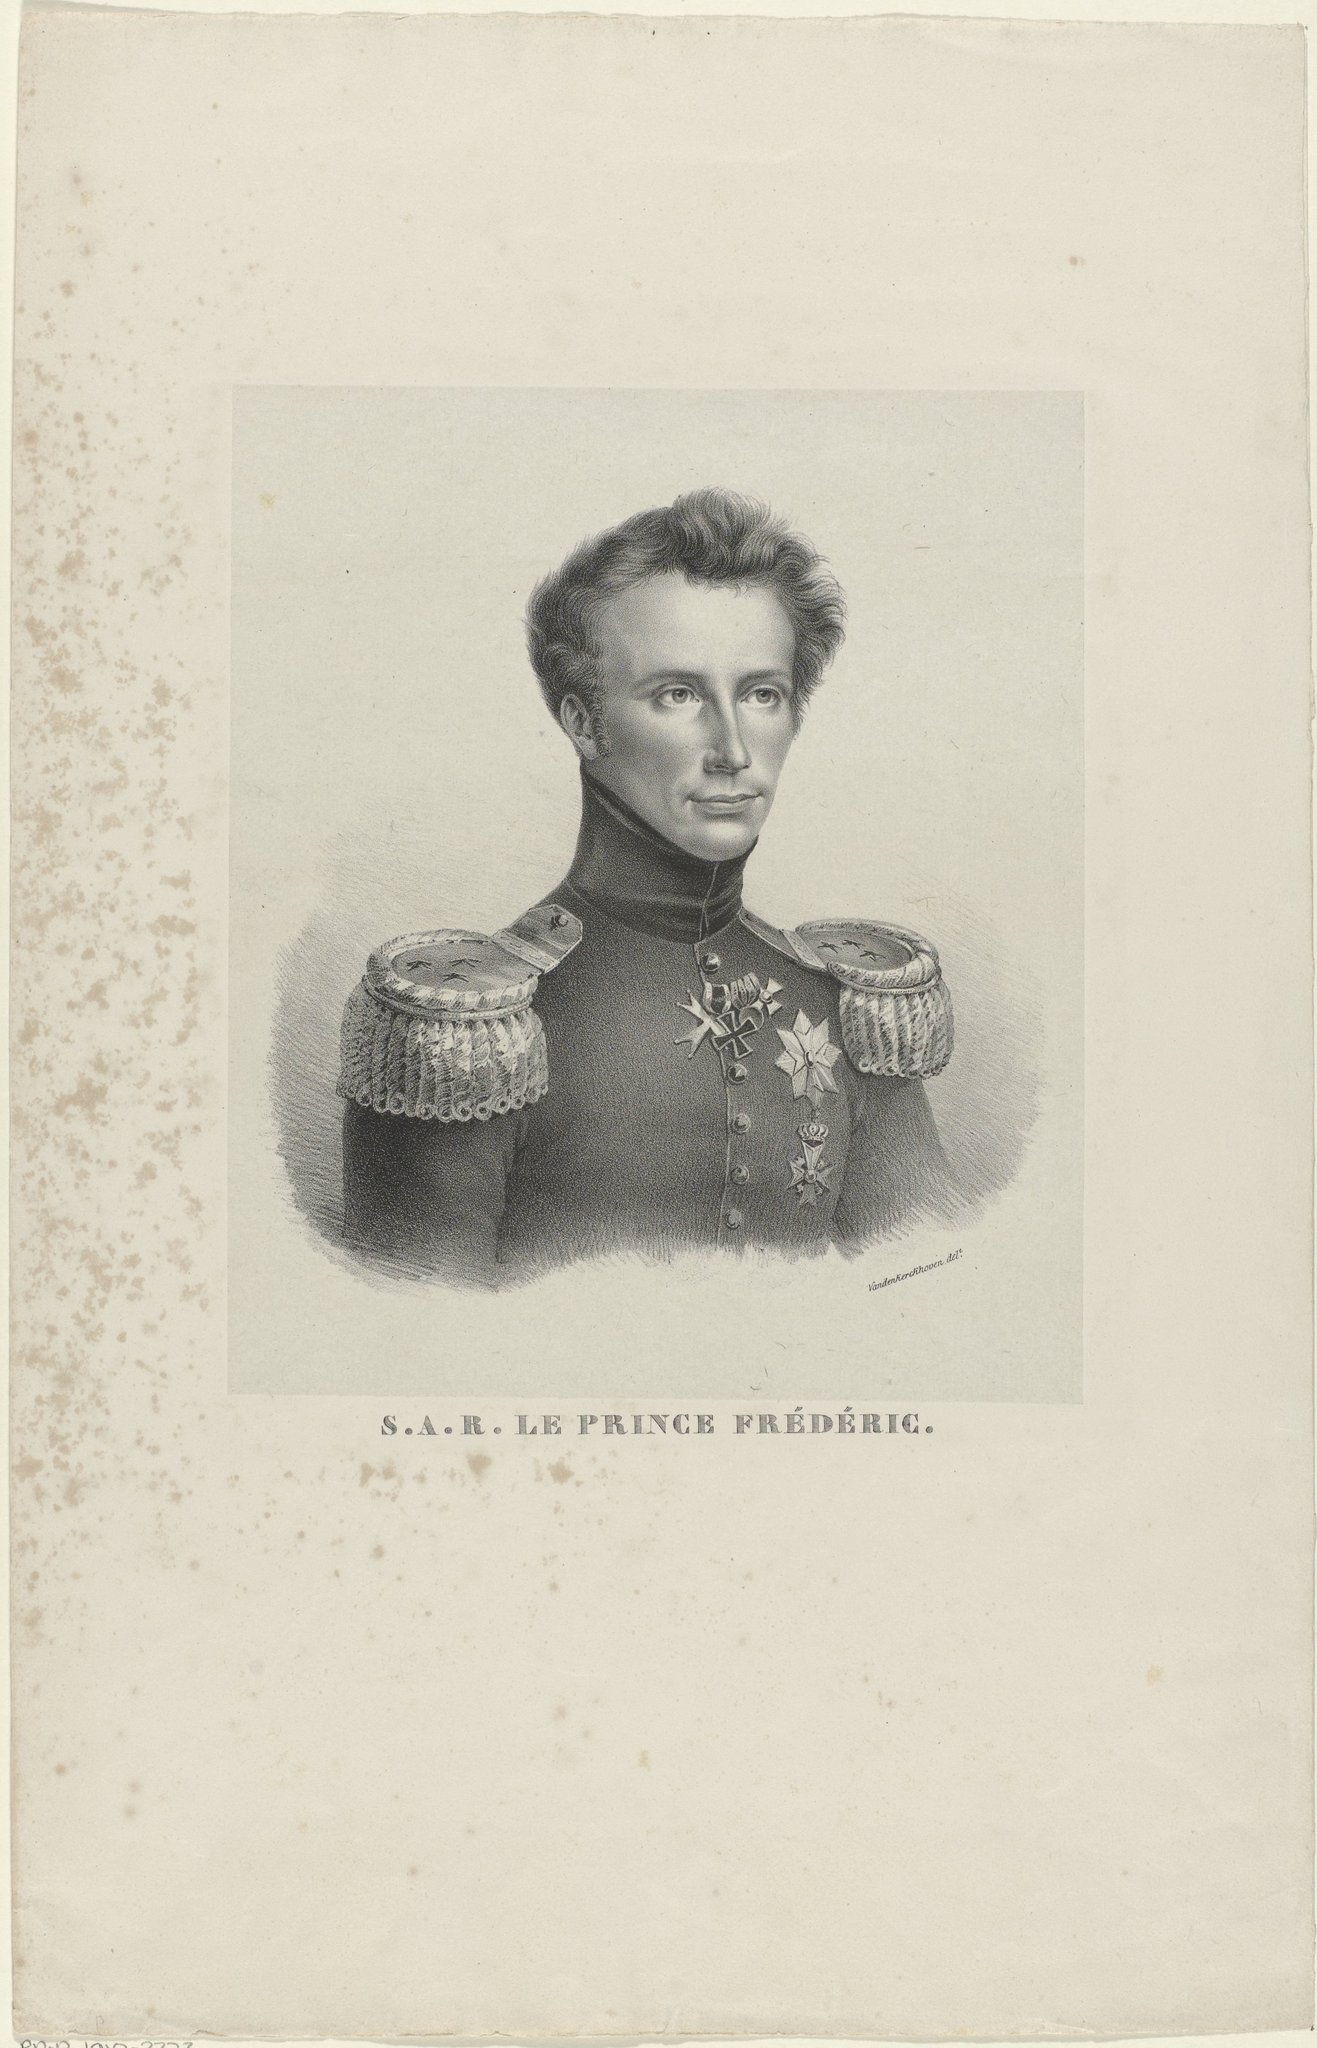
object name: print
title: Portret van Frederik, prins der Nederlanden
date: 1815-1899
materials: paper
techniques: lithograph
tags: berlin, frederik (prins der nederlanden)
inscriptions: collector's mark: Lugt 2228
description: De hier vermelde titel verwijst naar de hoogst verkregen titel van de geportretteerde, niet per se naar de titel die de geportretteerde op deze voorstelling draagt.